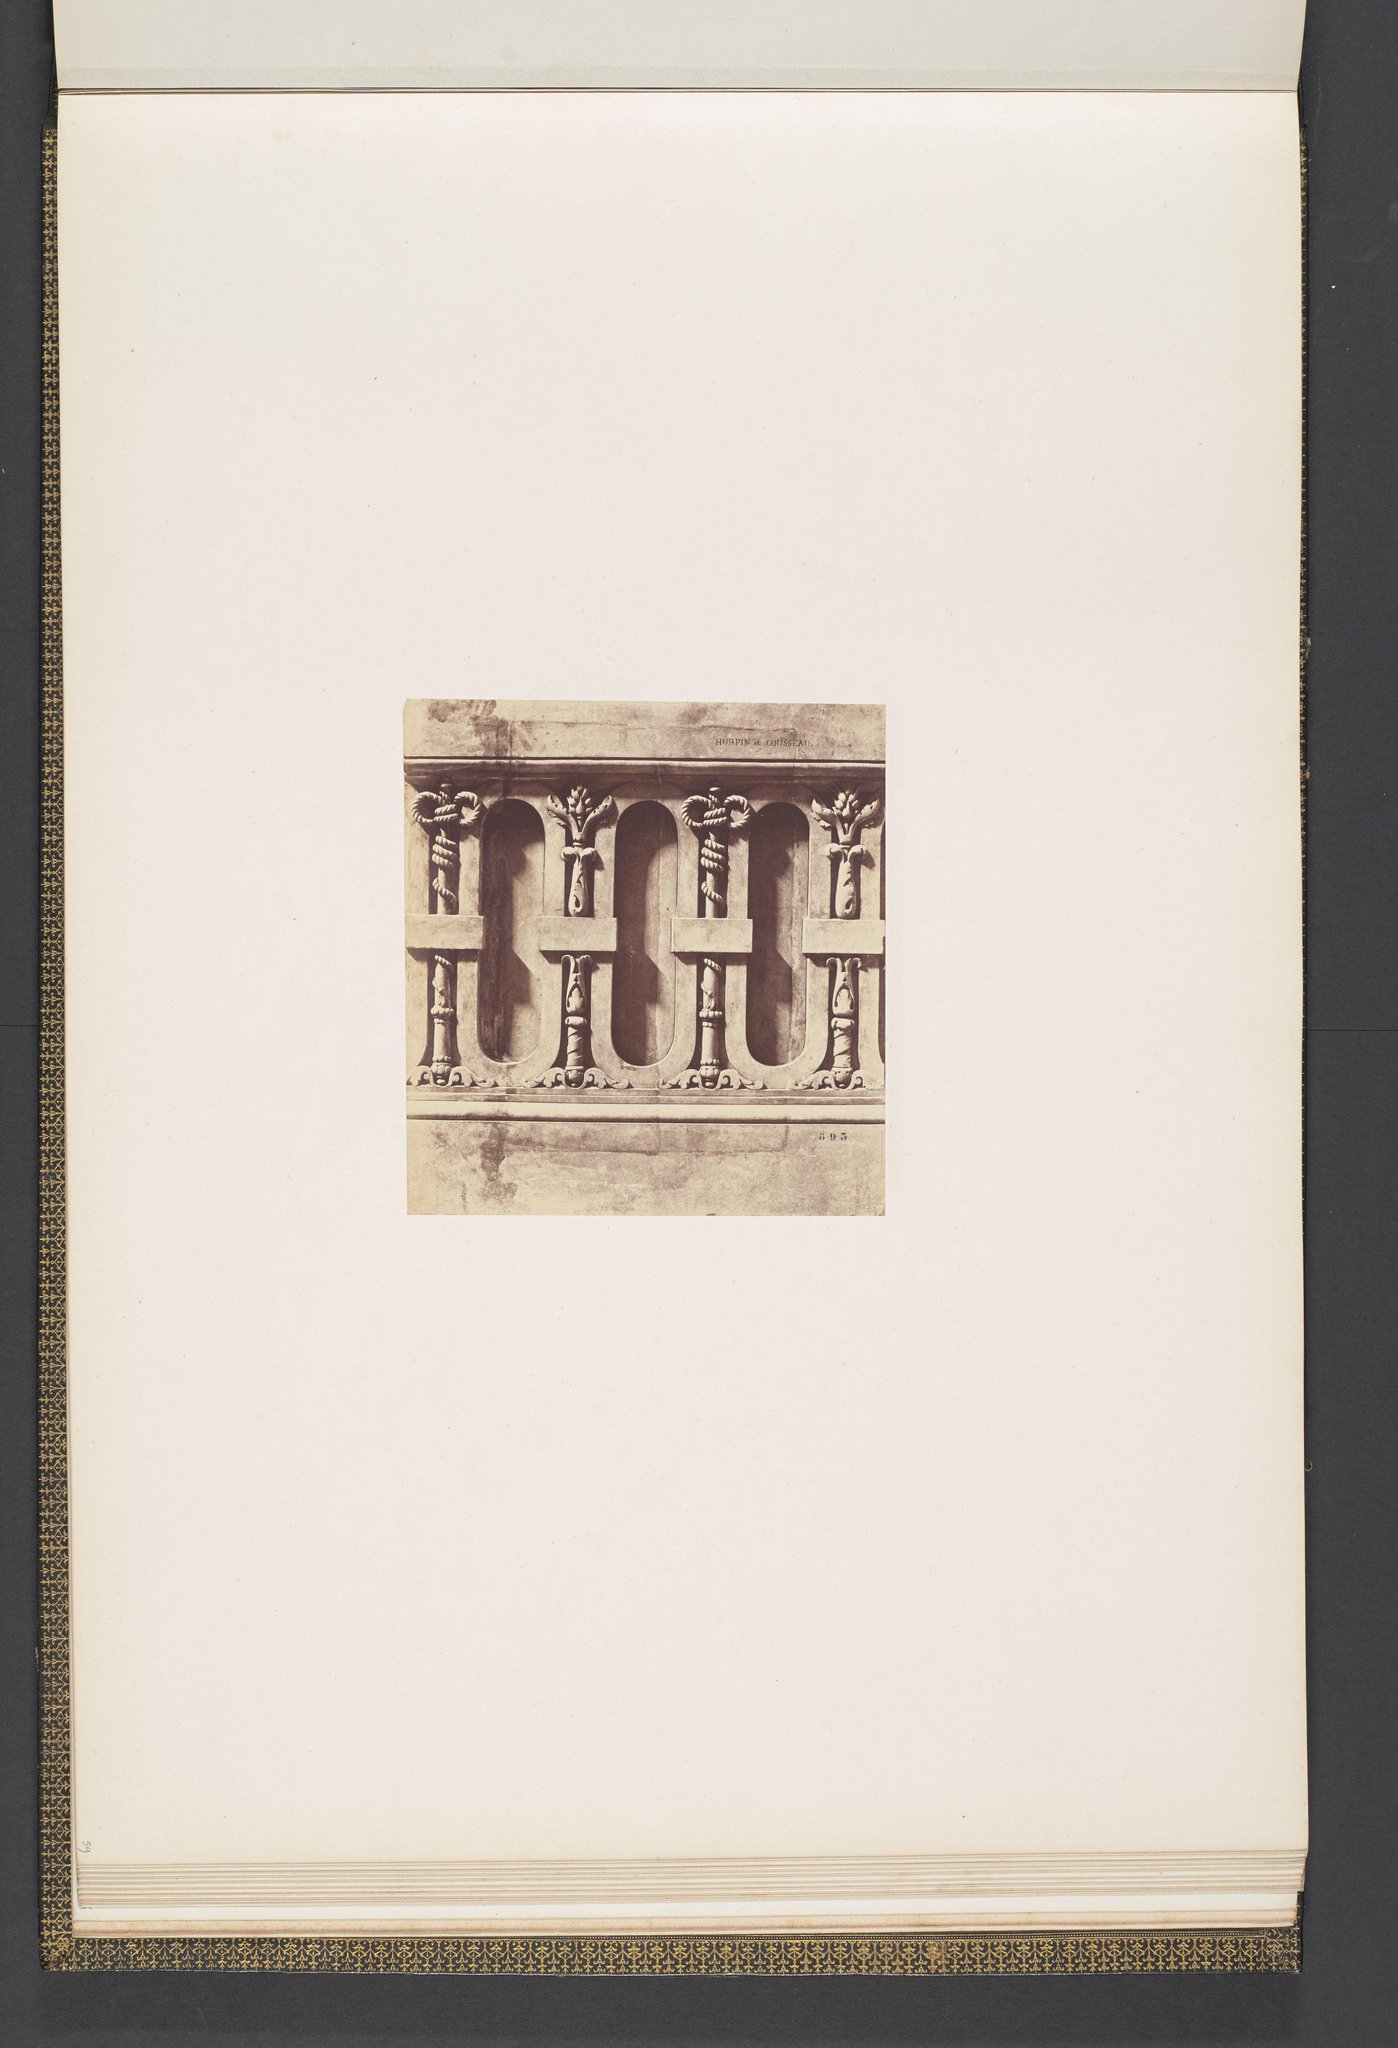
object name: photograph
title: Gipsmodel voor een versiering op het Palais du Louvre door Jean-Pierre Hurpin en Marie Etienne Cousseau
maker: édouard denis baldus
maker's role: fotograaf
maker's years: 1813-1889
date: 1855-1857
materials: paper, photographic support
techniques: salted paper print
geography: paris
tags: permanent exhibition, museum, ornamenting, decorating ~ applied arts, paris, tuileries palace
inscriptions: number: ‘893’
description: Onderdeel van Réunion des Tuileries au Louvre 1852-1857, album 3.